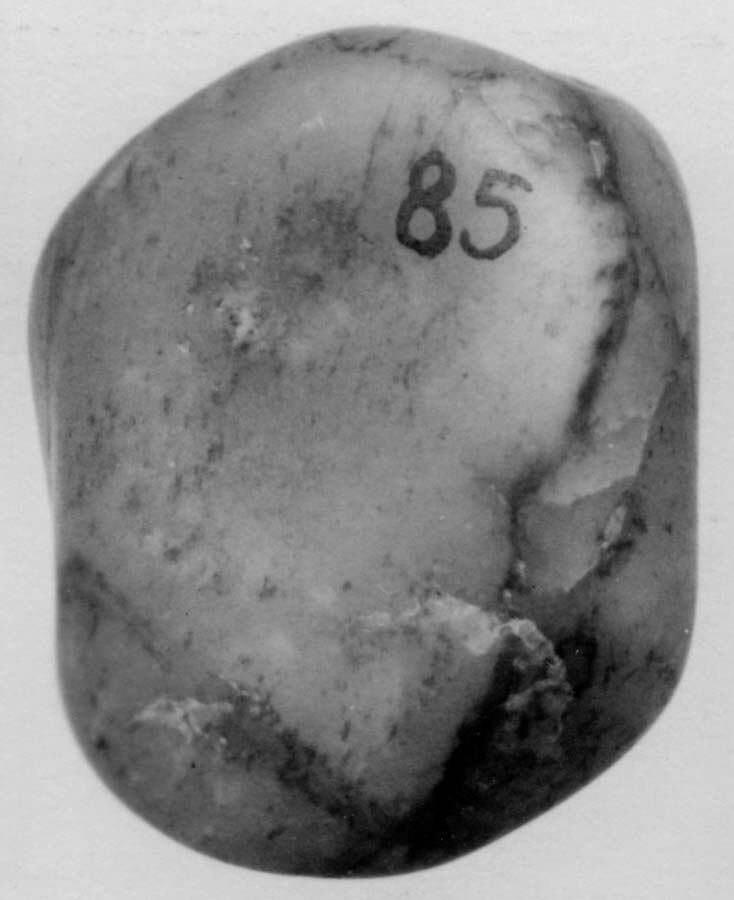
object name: pebble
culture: chinese or turkestani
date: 1902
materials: jade